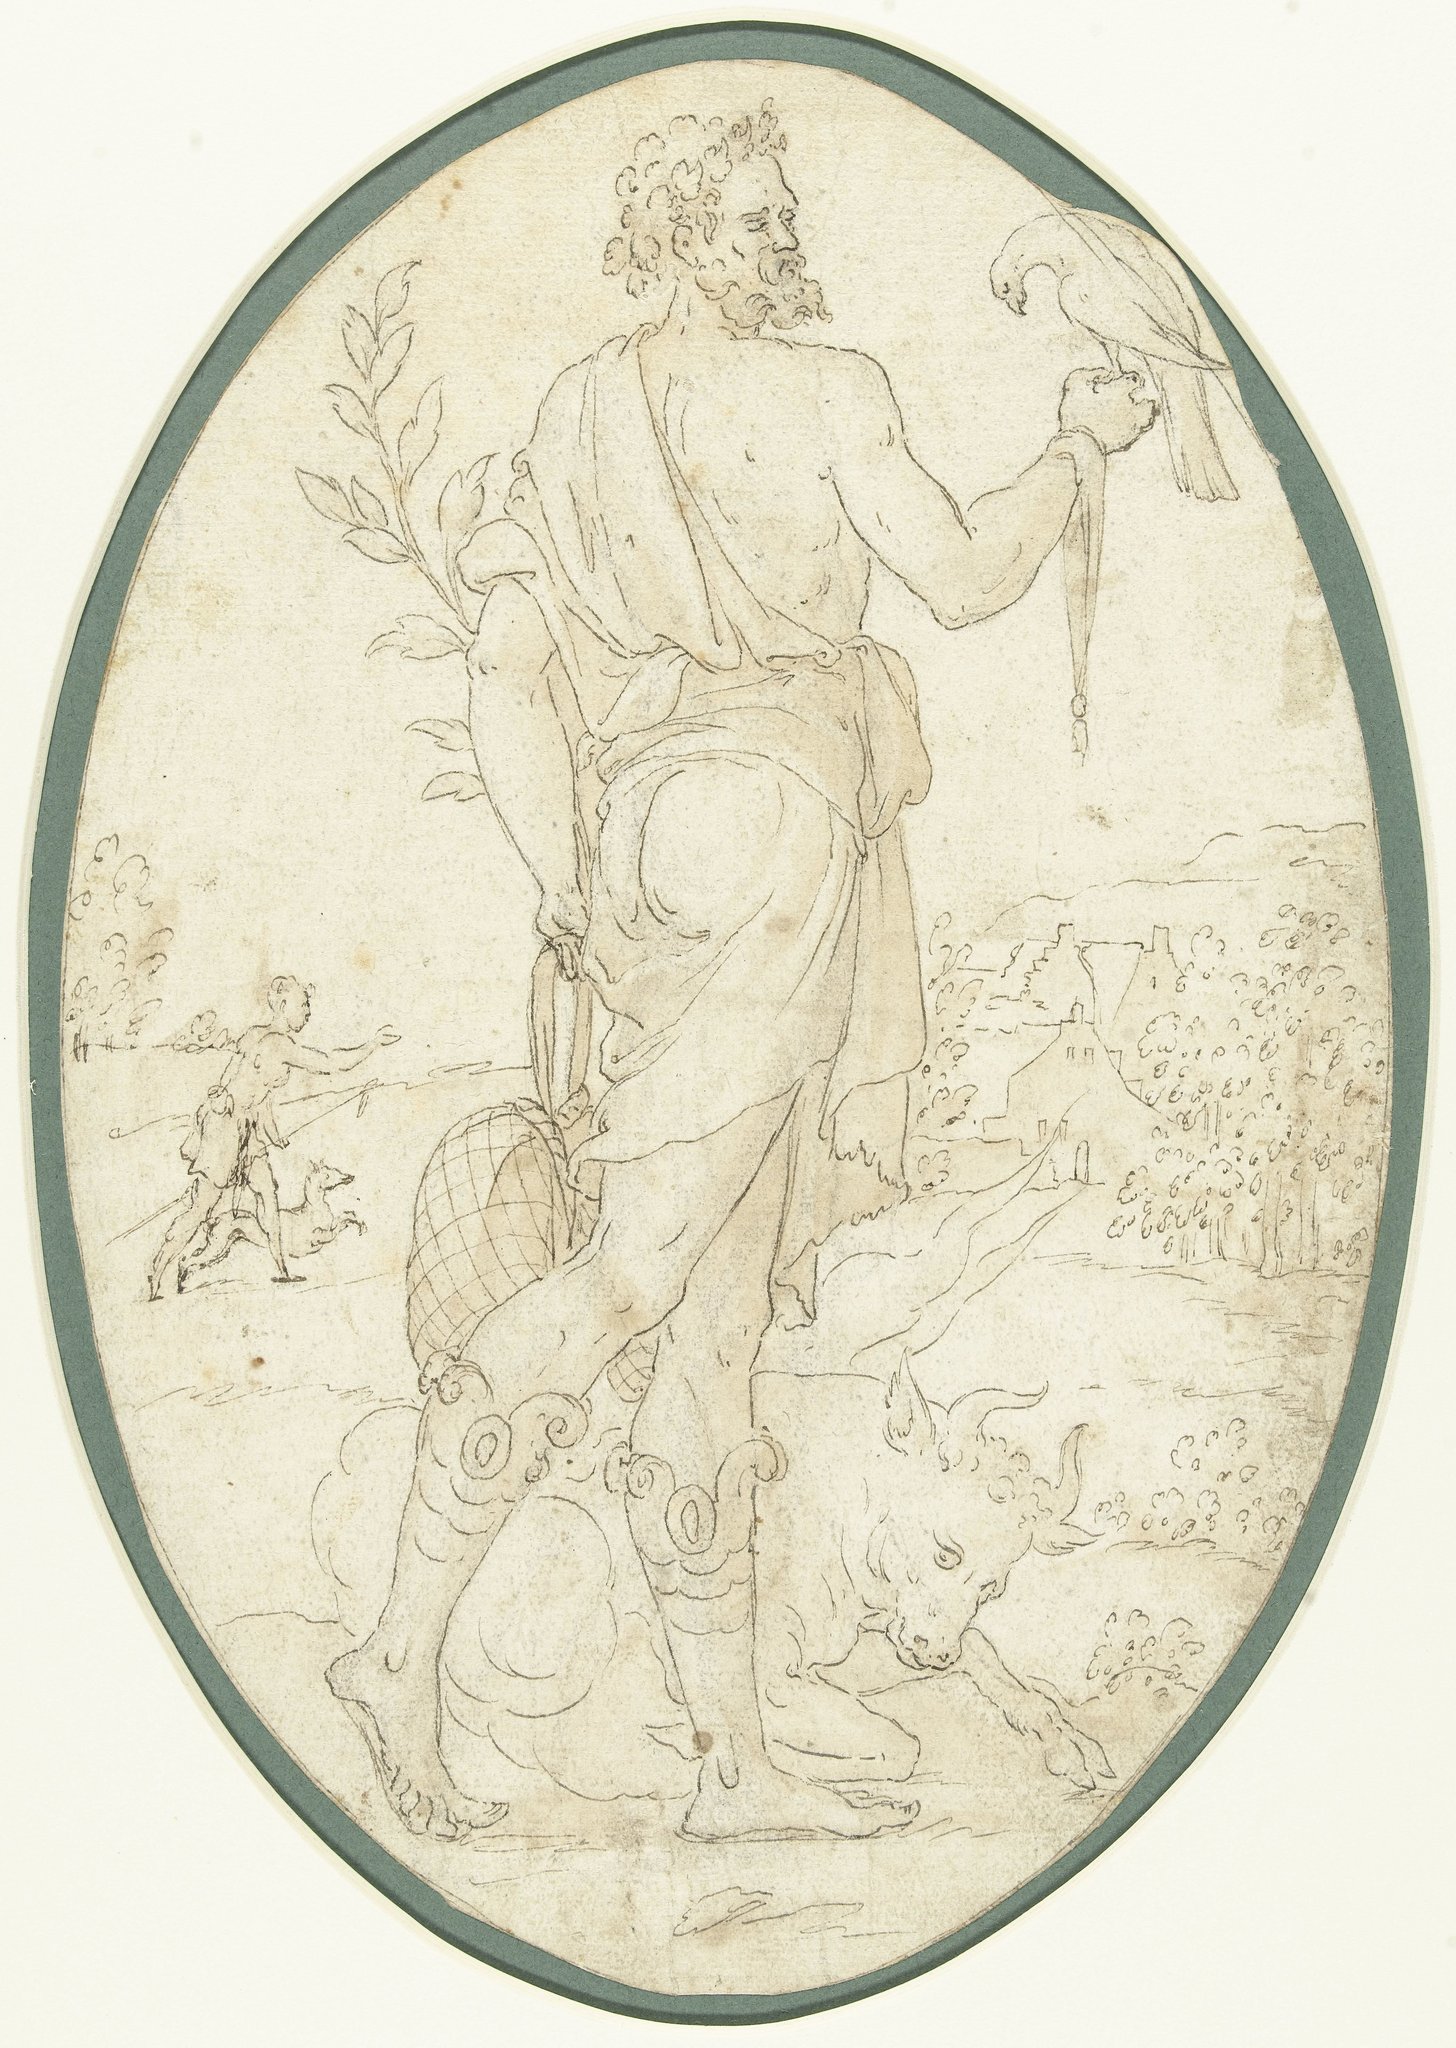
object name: drawing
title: April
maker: Anonymous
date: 1550-1600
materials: ink, paper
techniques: brush, pen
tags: april ~ other concepts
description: Personificatie van de maand April: staande man met valk op de hand; een stier ligt aan zijn voeten.